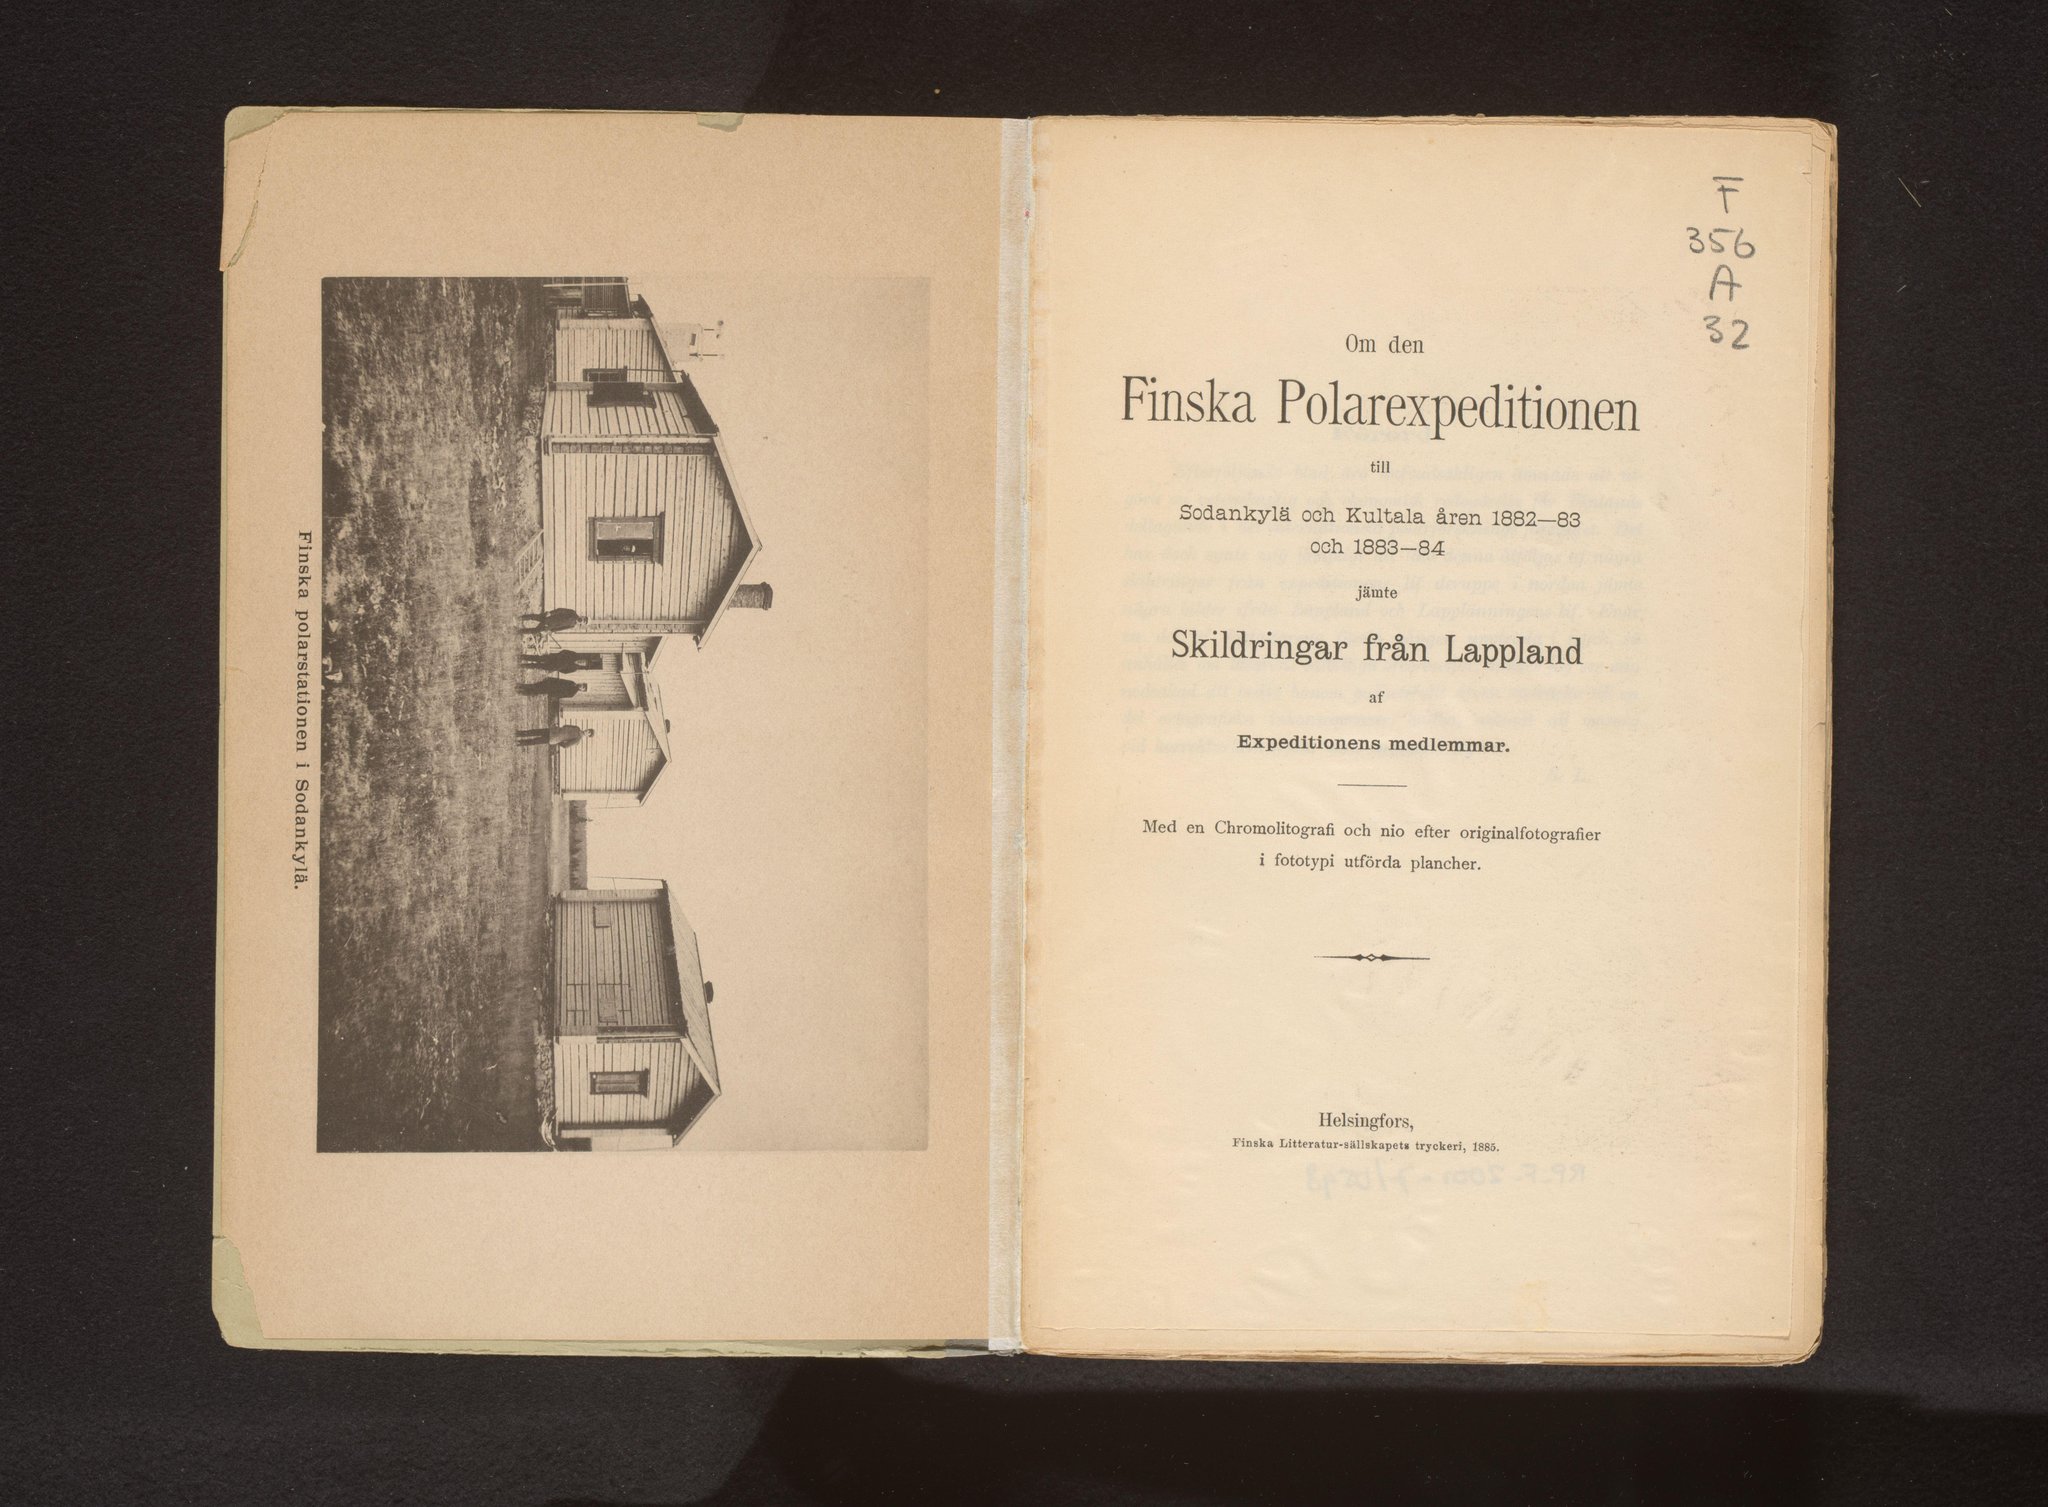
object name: photomechanical print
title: Exterieur van het Finse poolstation te Sodankylä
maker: karl granit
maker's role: fotograaf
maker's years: 1857-1894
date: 1875-1885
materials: paper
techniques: photograph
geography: berlin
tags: landscapes in polar regions, façade (of house or building)